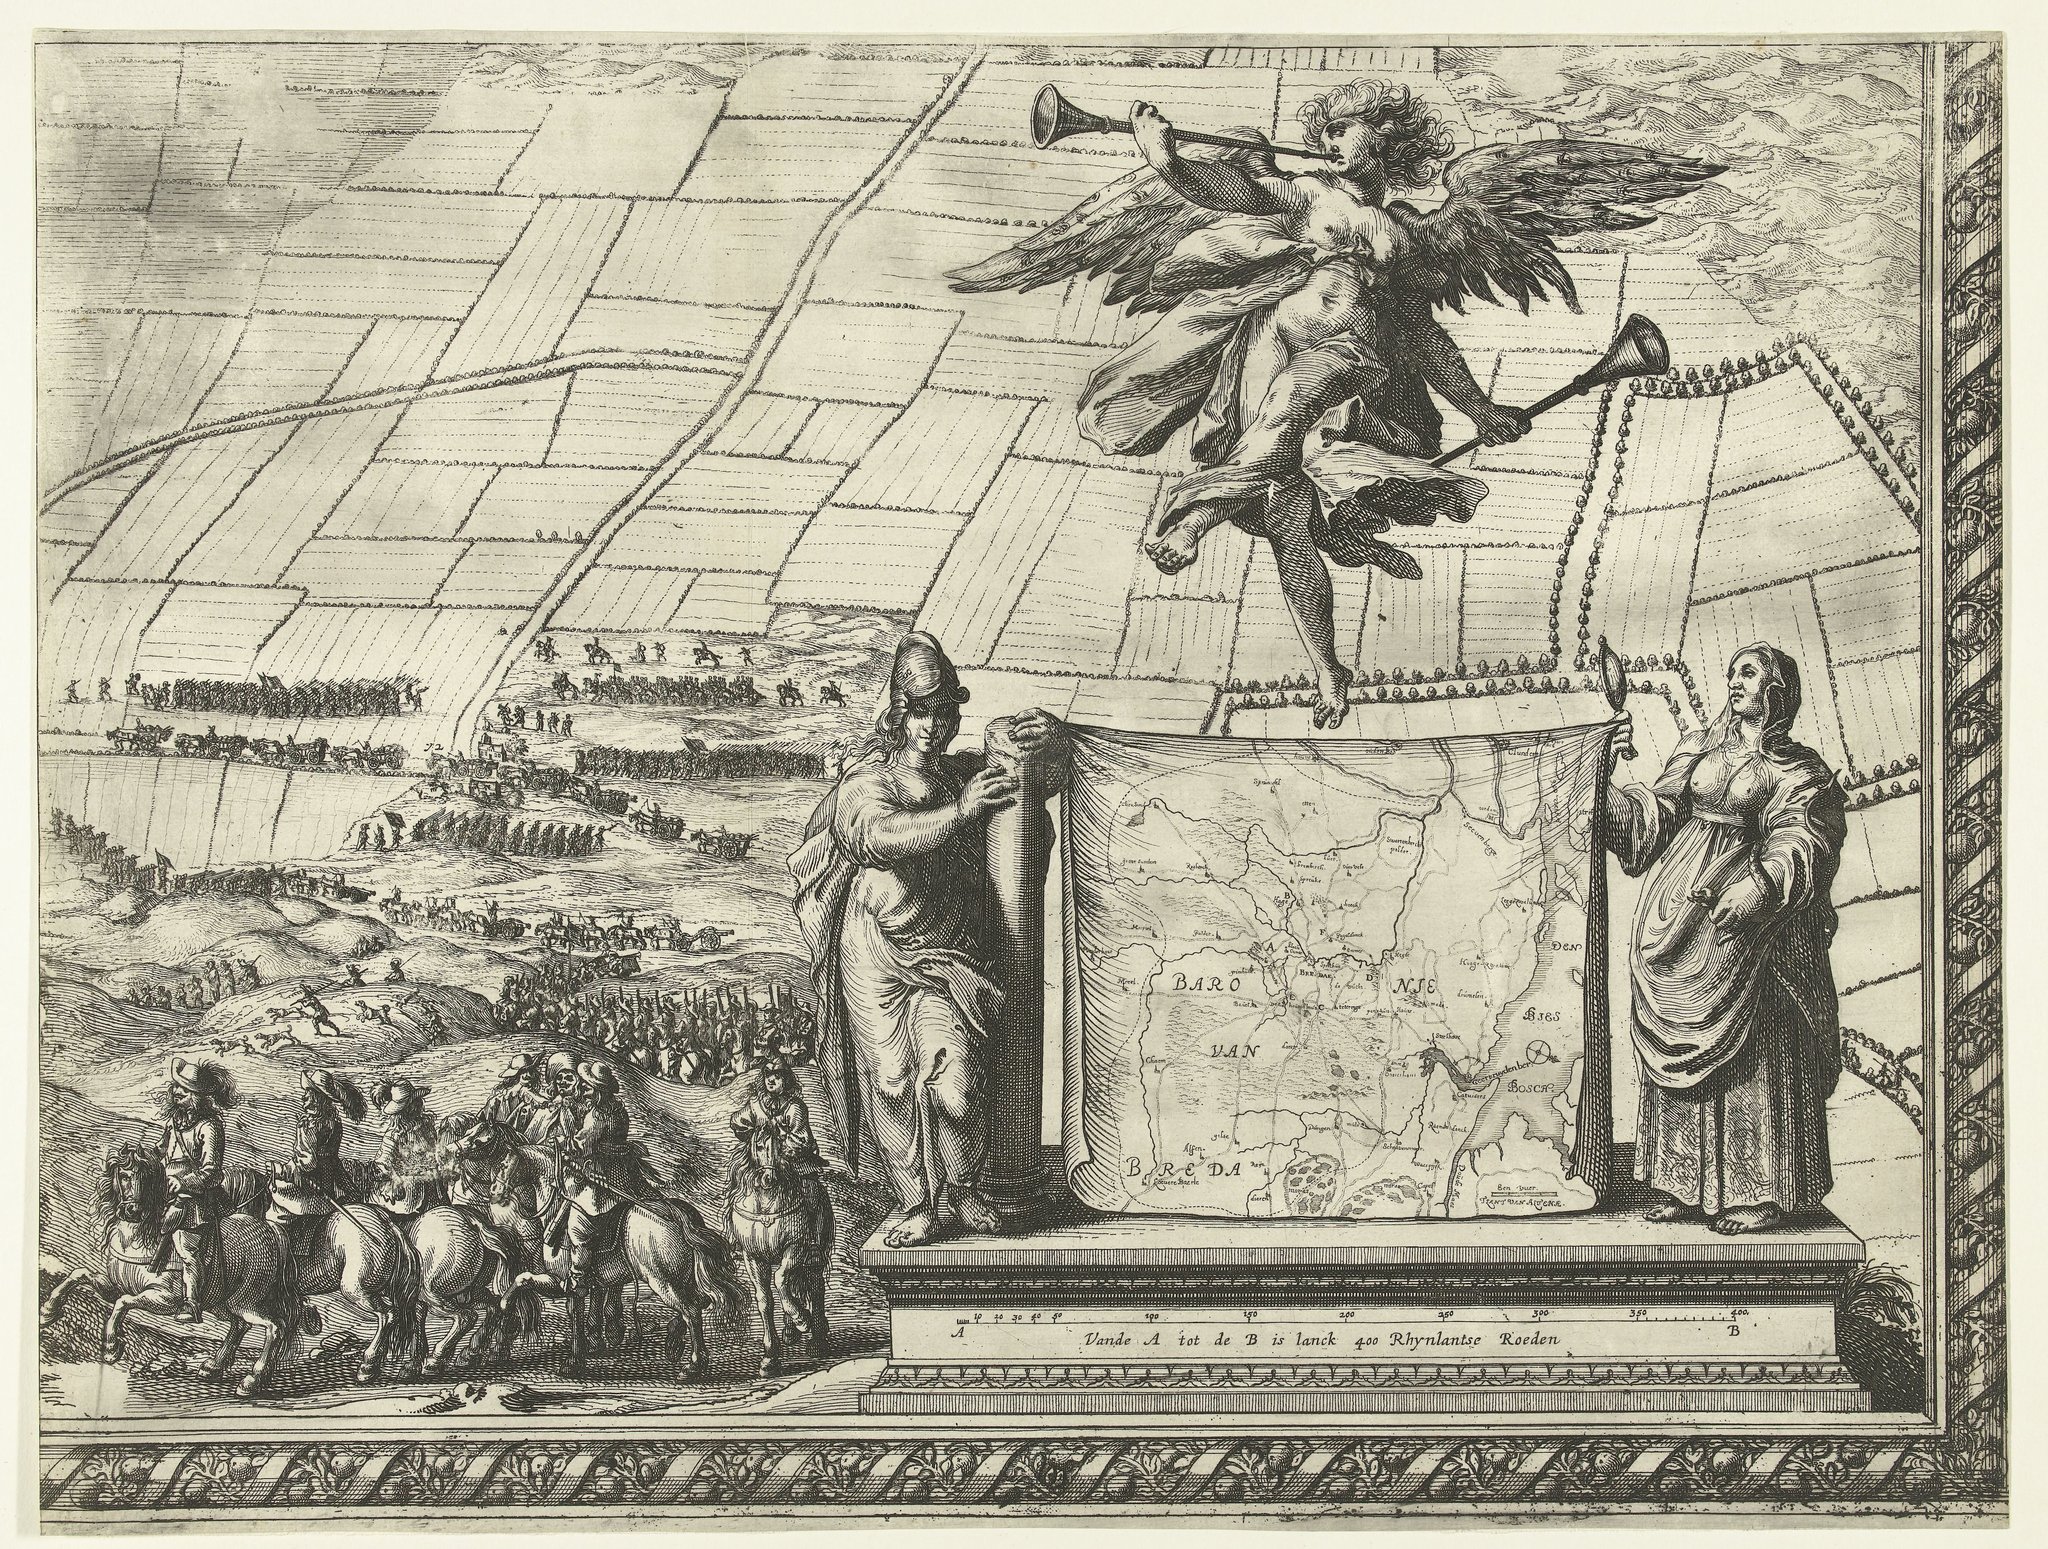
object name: print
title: Expugnatio Fortissimae Urbis Bredae Ao.-1637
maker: balthasar florisz. van berckenrode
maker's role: draughtsman, print maker, publisher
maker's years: 1591-1645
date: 1637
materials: paper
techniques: etching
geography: northern netherlands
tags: delft, frederick henry (prince of orange), fortitude, 'fortitudo' ~ one of the four cardinal virtues, prudence, 'prudentia'; 'prudenza' (ripa) ~ one of the four cardinal virtues, maps of separate countries or regions, siege, position war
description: De belegering en verovering van Breda door het Staatse leger onder Frederik Hendrik, 23 juli - 10 oktober 1637. Onderdeel van een ongemonteerde ensemble bestaande uit 9 bladen (en 2 hier ontbrekende tekstbladen). Blad rechtsonder met officieren te paard, een deel van de kaart en een voetstuk met een kaart van de baronie van Breda opgehouden door de personificaties van de deugden Kracht en Voorzichtigheid. In de lucht de Faam met twee bazuinen.